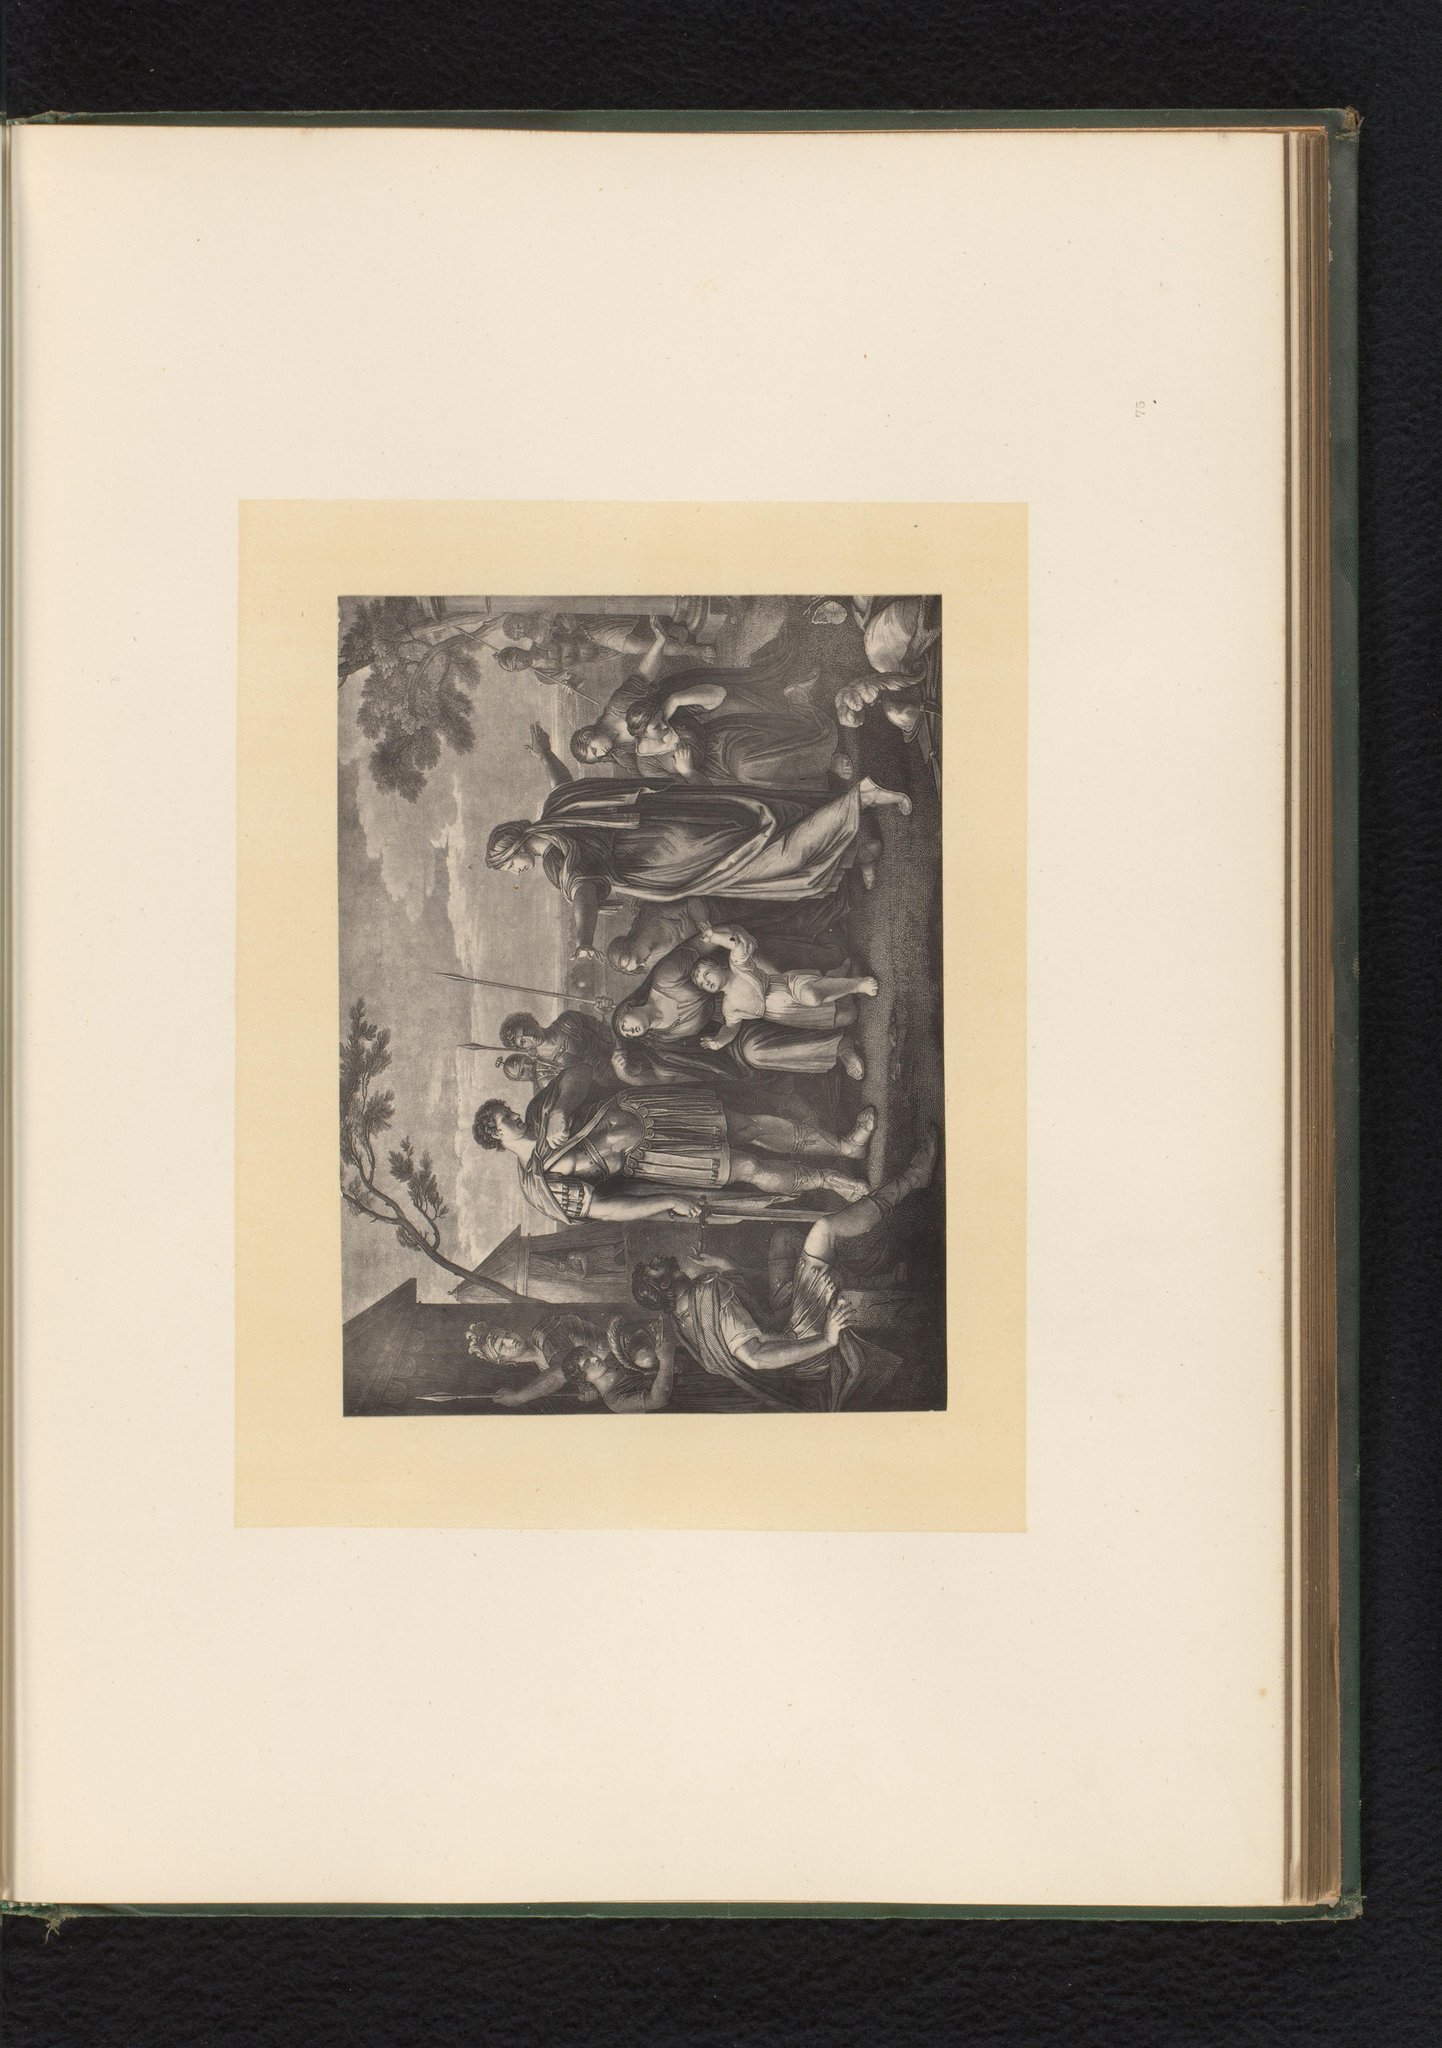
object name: reproduction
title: Coriolanus, Act V, Scene 3: The Tent of Coriolanus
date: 1874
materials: paper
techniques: woodburytype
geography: london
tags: theatre, theatrical performance